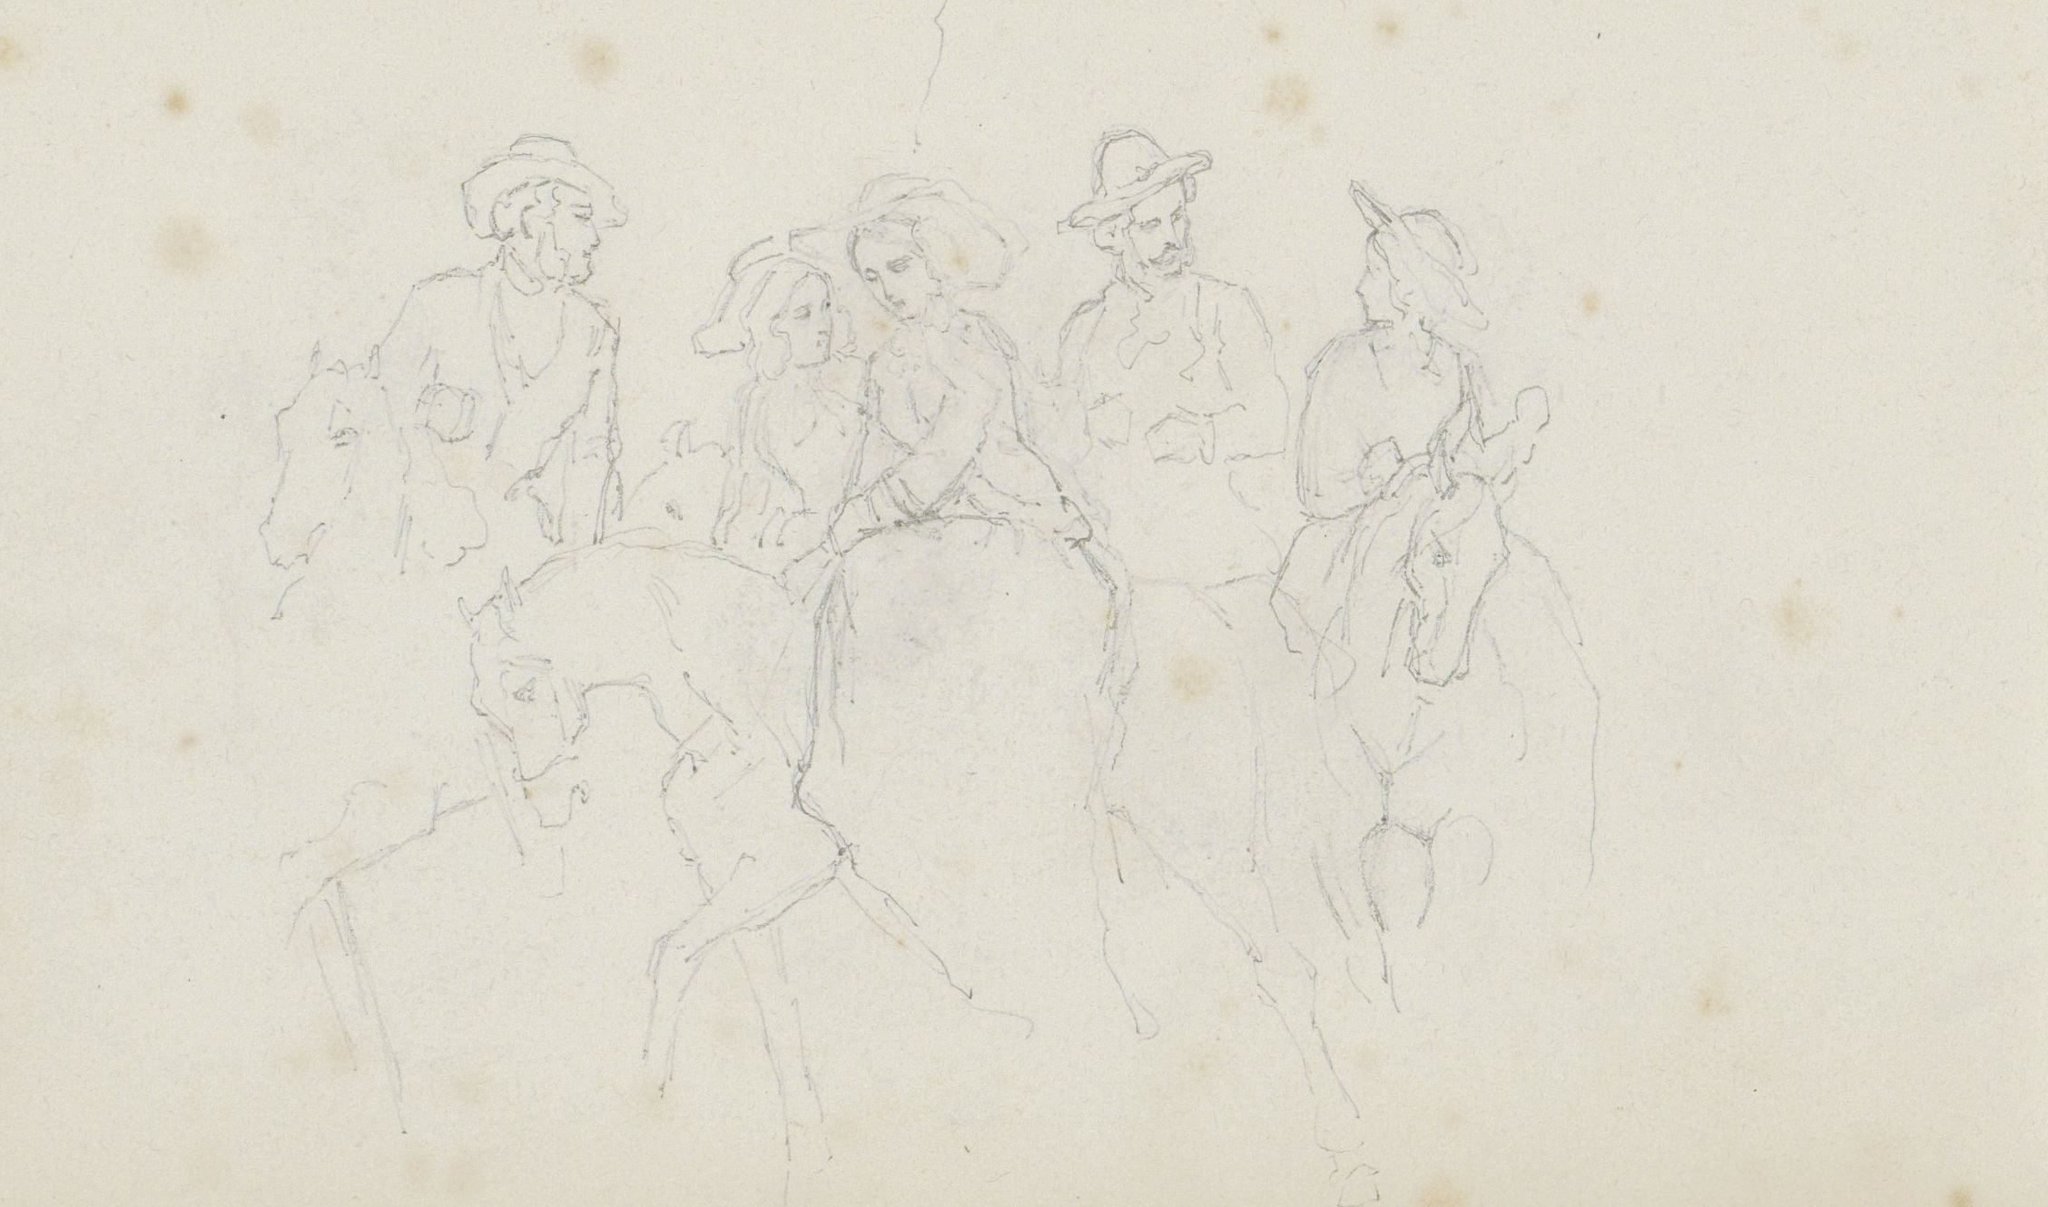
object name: sketchbook leaf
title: Gezelschap van ruiters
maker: charles rochussen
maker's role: draughtsman, painter, print maker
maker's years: 1814-1894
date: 1840-1860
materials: paper, pencil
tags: riding a horse, ass, or mule; rider, horseman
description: Blad 26 verso uit een schetsboek met 38 bladen.